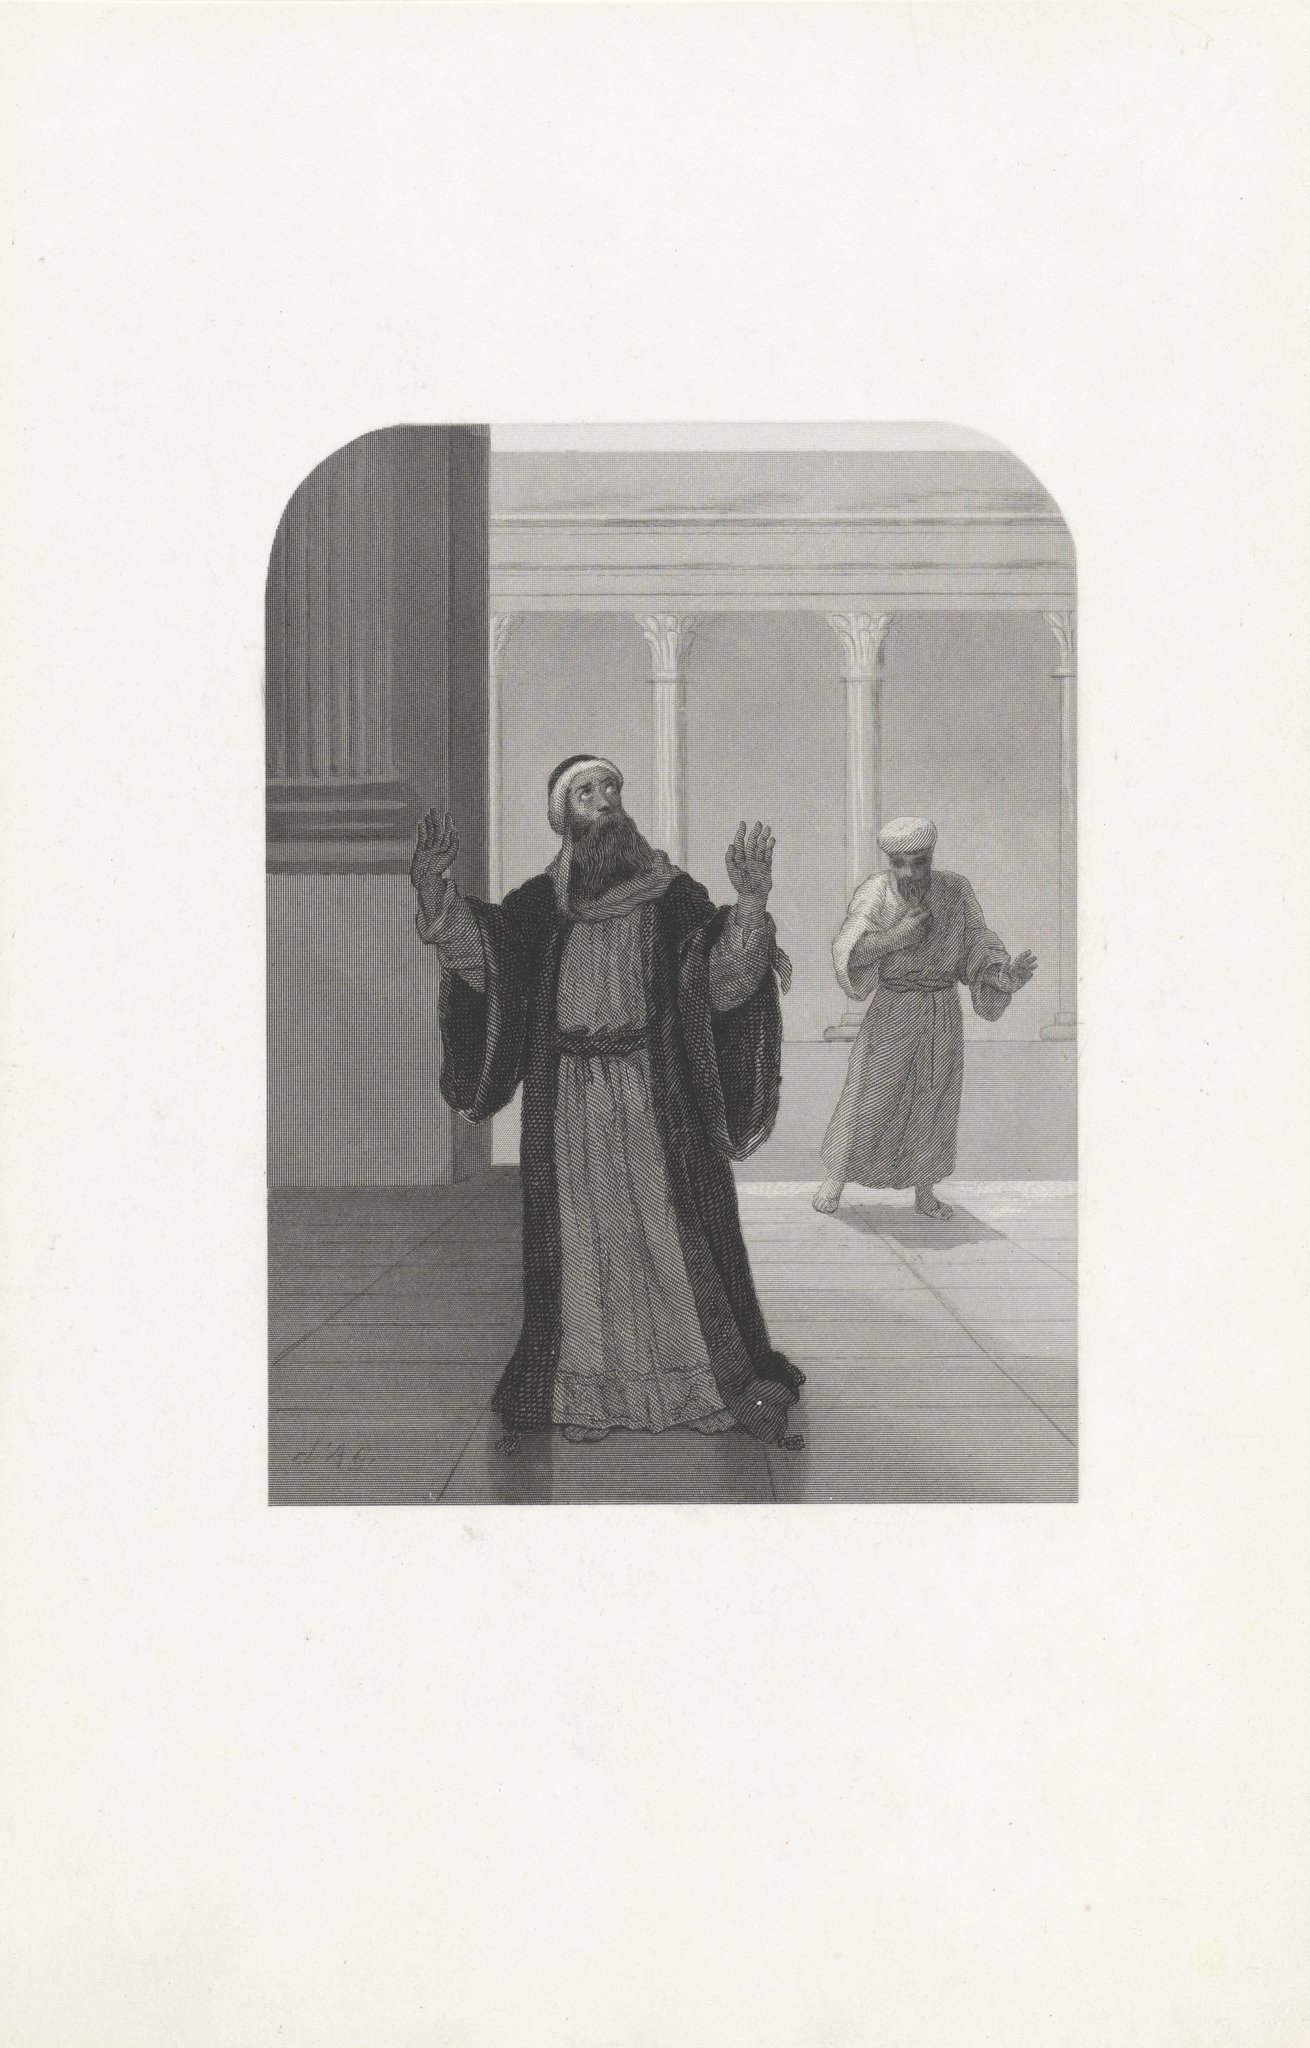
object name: print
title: Biddende mannen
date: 1826-1886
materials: paper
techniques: engraving, etching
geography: amsterdam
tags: head-gear: turban, one person praying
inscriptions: collector's mark: Lugt 2228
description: In man in Arabische kledij staat op een door een zuilengaanderij omgeven binnenplaats. Hij heft zijn ogen en handen ten hemel. Achter hem een tweede man, eveneens met tulband en ook in eerbiedige houding.